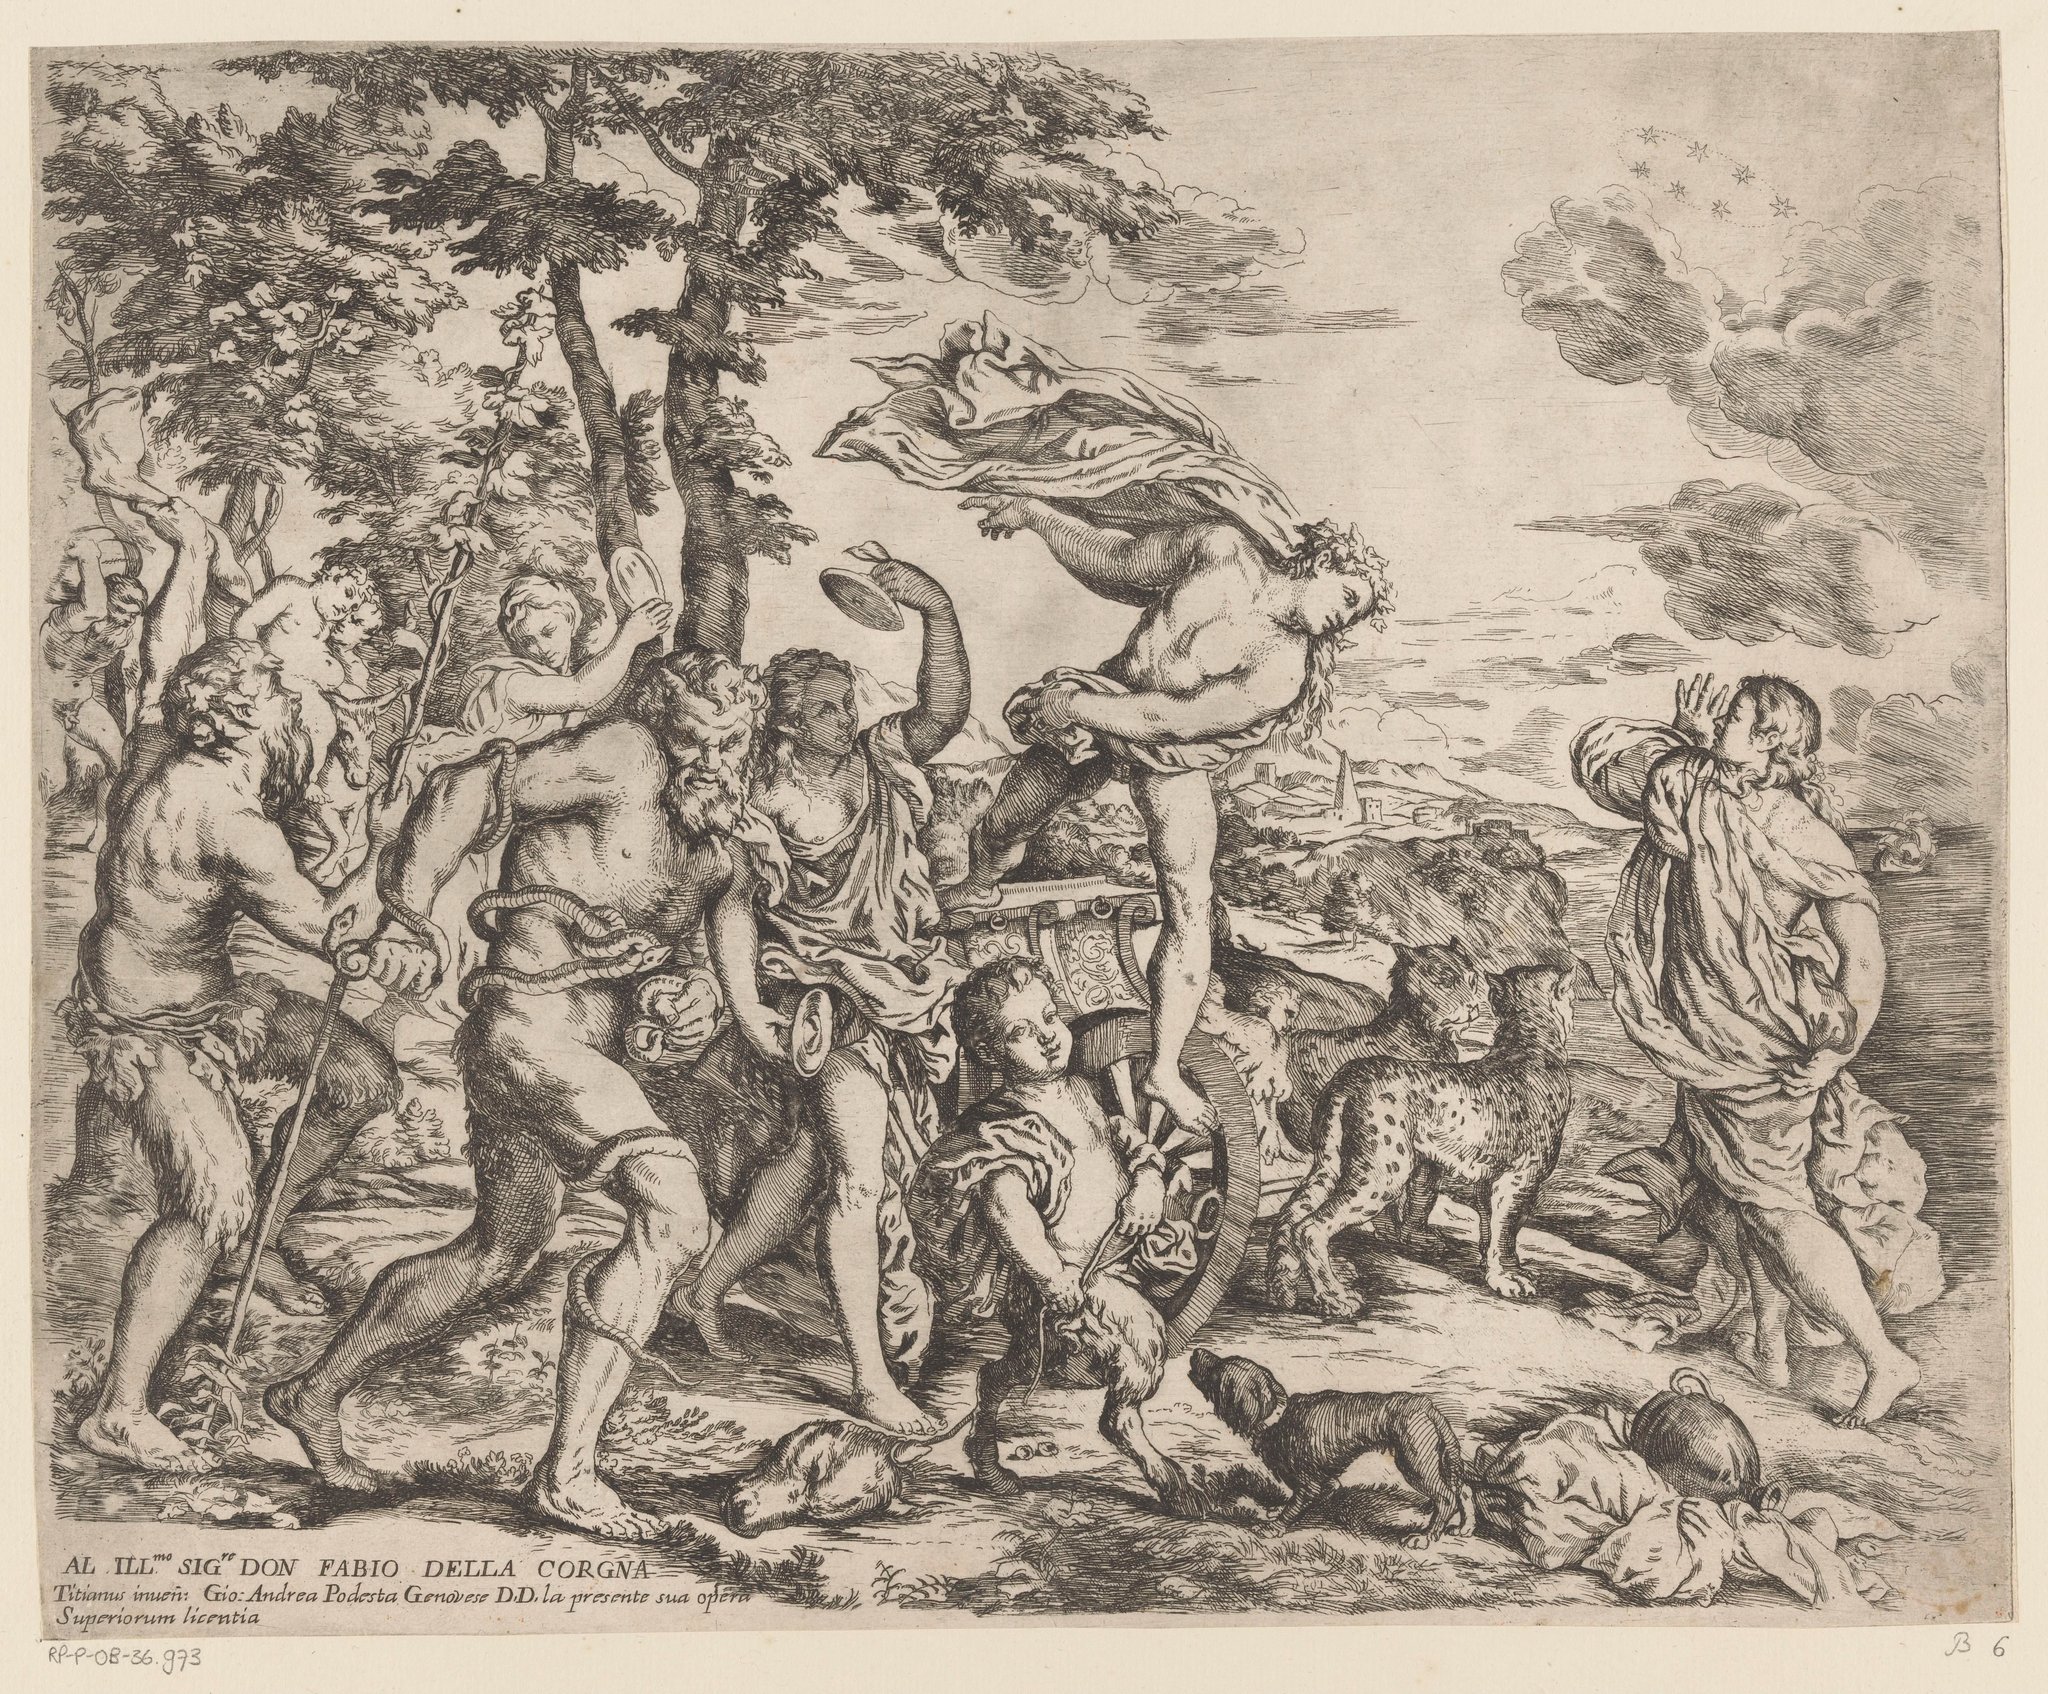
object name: print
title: Bacchus ontmoet Ariadne op Naxos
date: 1618-1674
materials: paper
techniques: etching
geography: italy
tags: bacchus finds ariadne on naxos, (story of) ariadne and bacchus, bacchanal: bacchus with his wine-flushed train (thiasos)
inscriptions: collector's mark: Lugt 240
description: De originele drukplaat wordt bewaard in de Calcografia Nazionale te Rome (inv.nr. 1051). Naar een schilderij door Titiaan in de National Gallery in Londen.